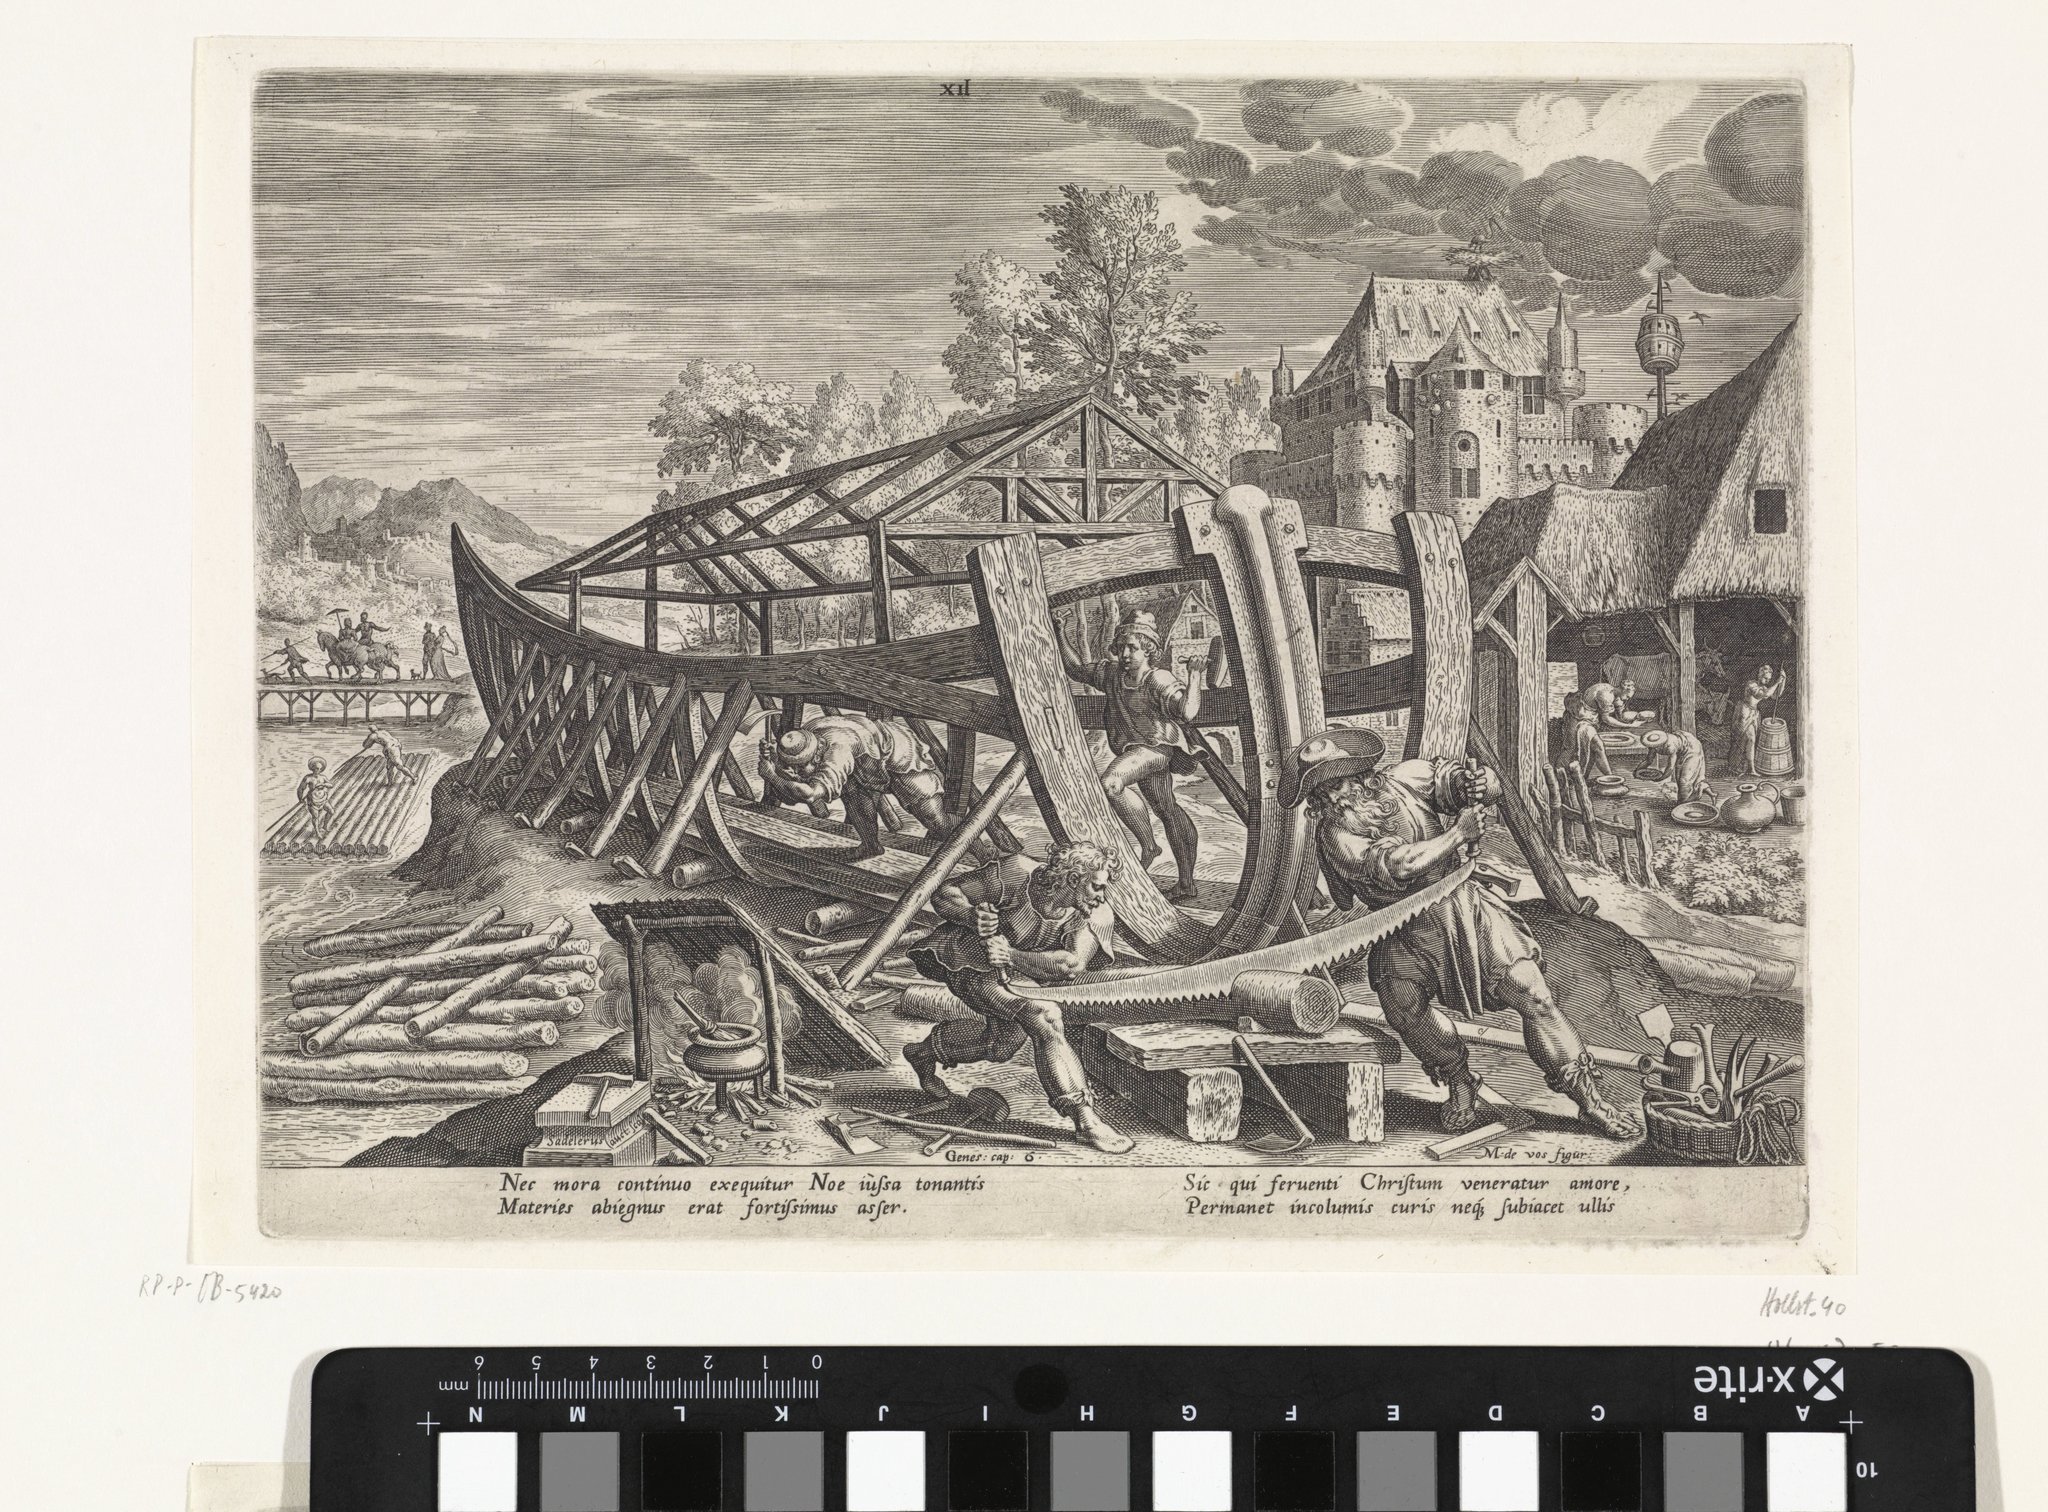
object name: print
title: Geschiedenis van de familie van Set / Over het goed en het slecht oordelen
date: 1586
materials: paper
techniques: engraving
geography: antwerp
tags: noah building the ark with the help of his sons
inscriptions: collector's mark: Lugt 240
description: Noach en zijn zonen bouwen de ark. De prent heeft een Latijns onderschrift.